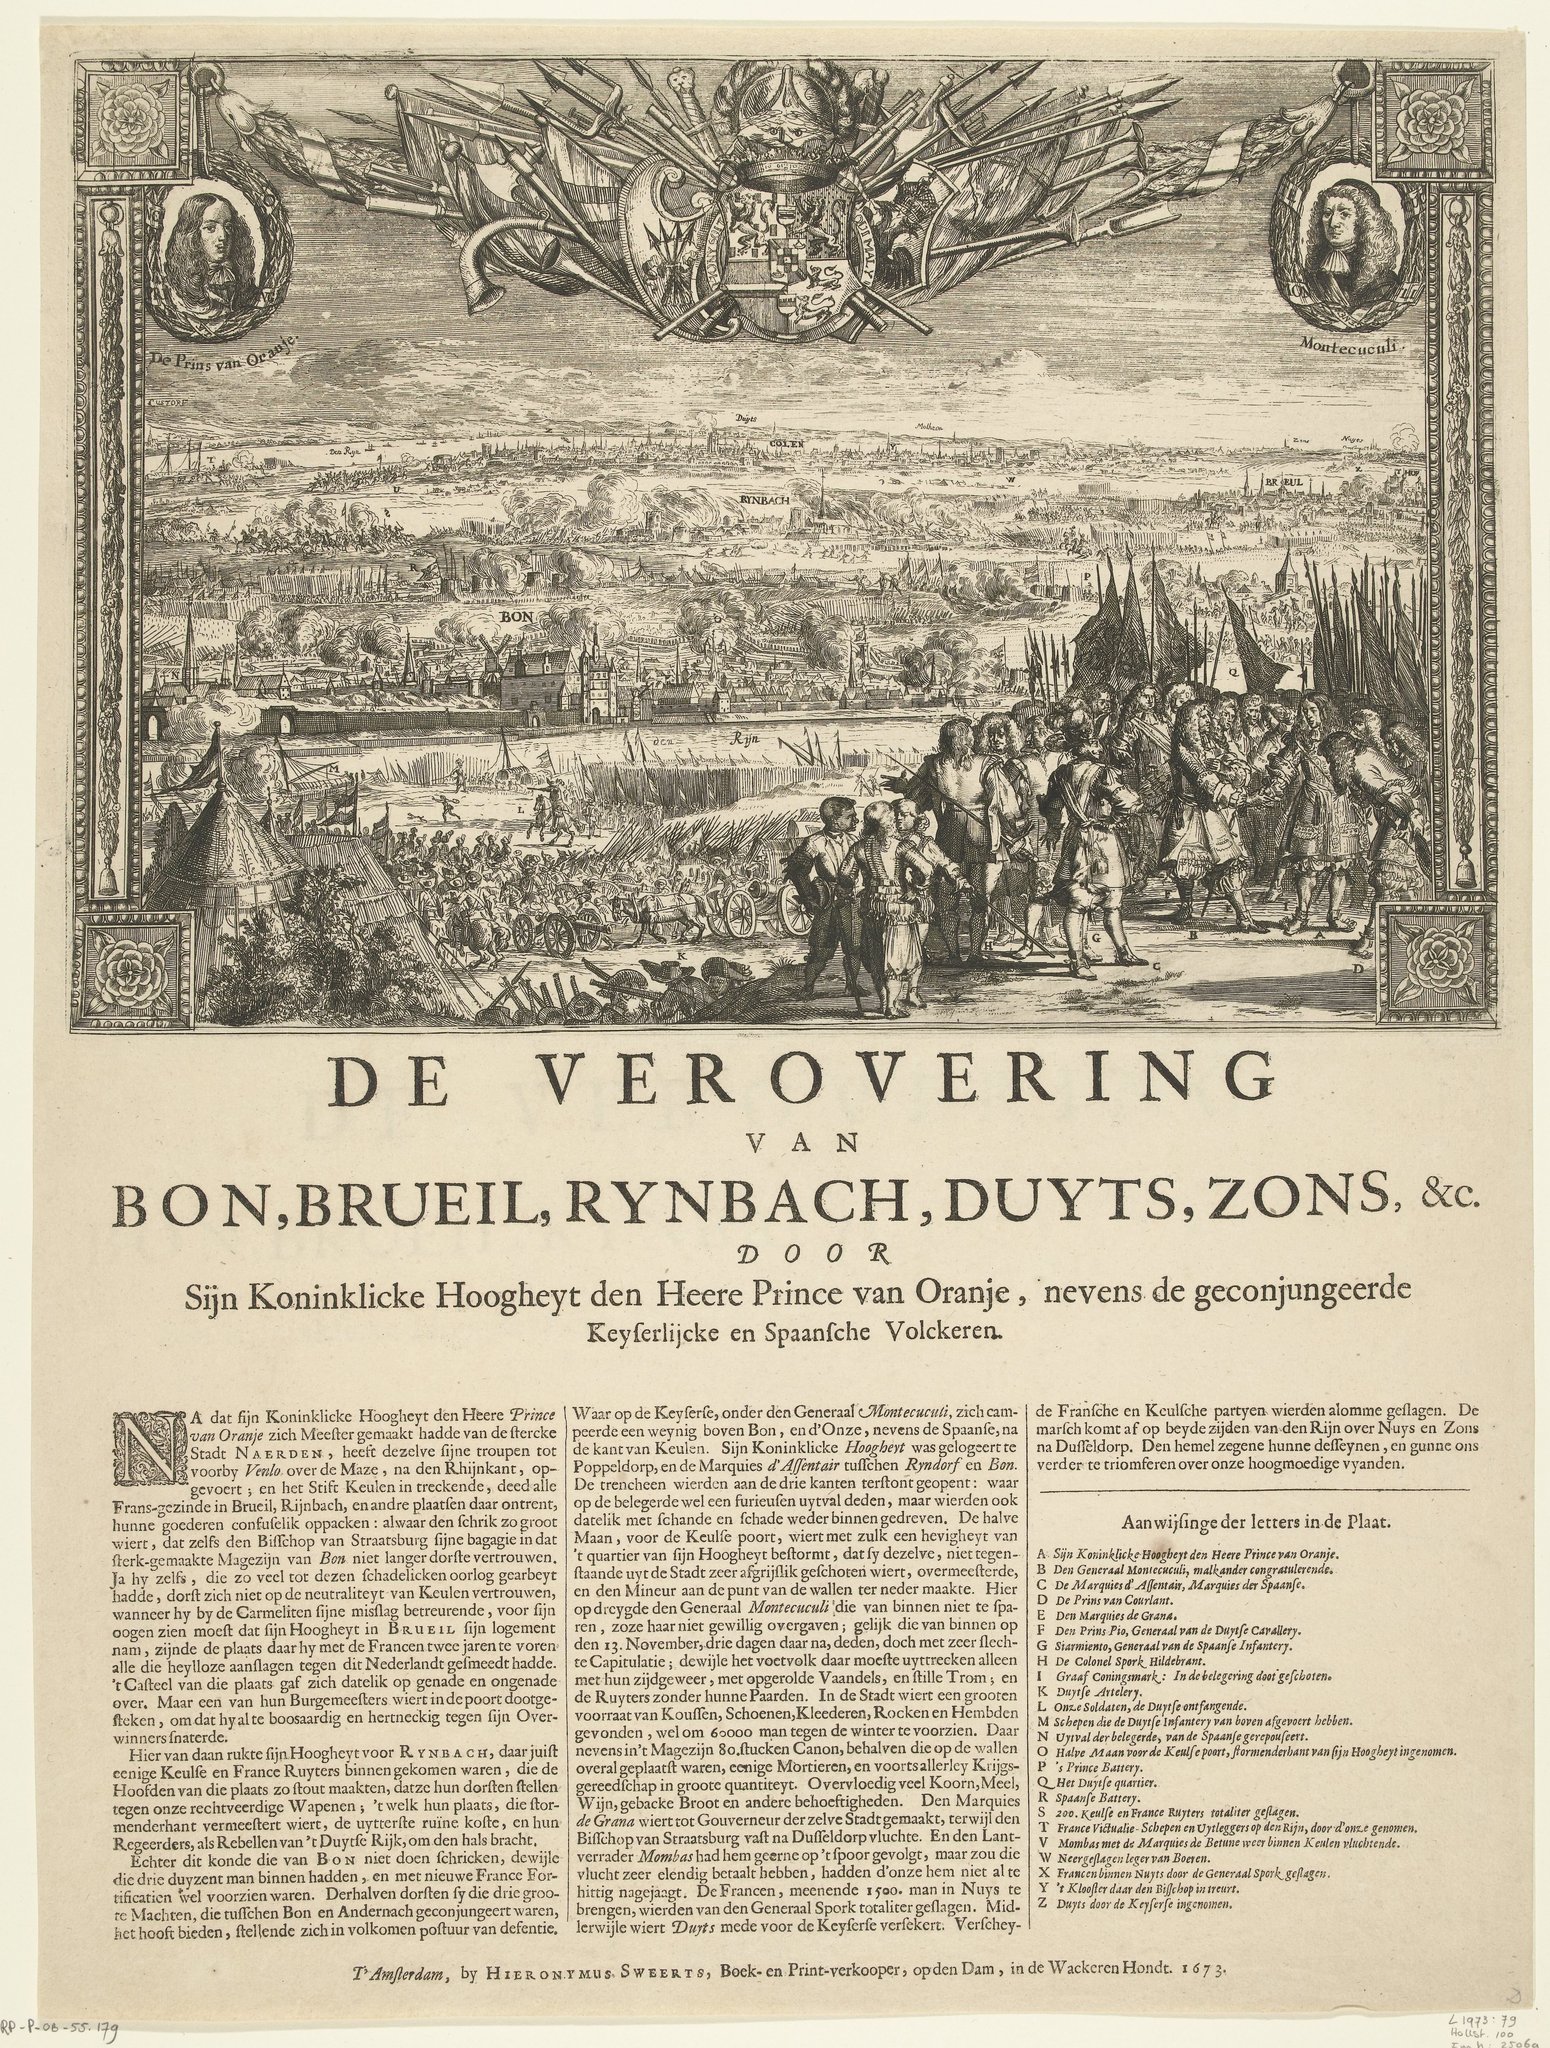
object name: print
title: De Verovering van Bon, Brueil, Rynbach, Duyts, Zons, &c. Door Sijn Koninklicke Hoogheyt den Heere Prince van Oranje, nevens de geconjugeerde Keyserlijcke en Spaansche Volckeren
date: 1673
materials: paper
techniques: engraving, etching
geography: netherlands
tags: the hague, william iii (prince of orange and king of england, scotland, and ireland), battle, fighting in general, rampjaar (disaster year)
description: Verovering van Bonn, Rheinbach, Brühl en andere Duitse steden door de prins van Oranje, 1673. Gezicht op de aan de Rijn gelegen Duitse steden in vogelvluchtperspectief. Op de voorgrond rechts feliciteren de prins en graaf Montecuccoli elkaar. Bovenaan een wapentrofee rond het wapen van de prins, links een portret van de prins, rechts het portret van Montecuccoli. Onder de voorstelling een beschrijving van de gebeurtenissen en de legenda A-Z in 3 kolommen in het Nederlands.